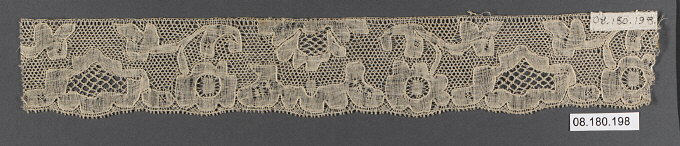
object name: fragment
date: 1801-1900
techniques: lace